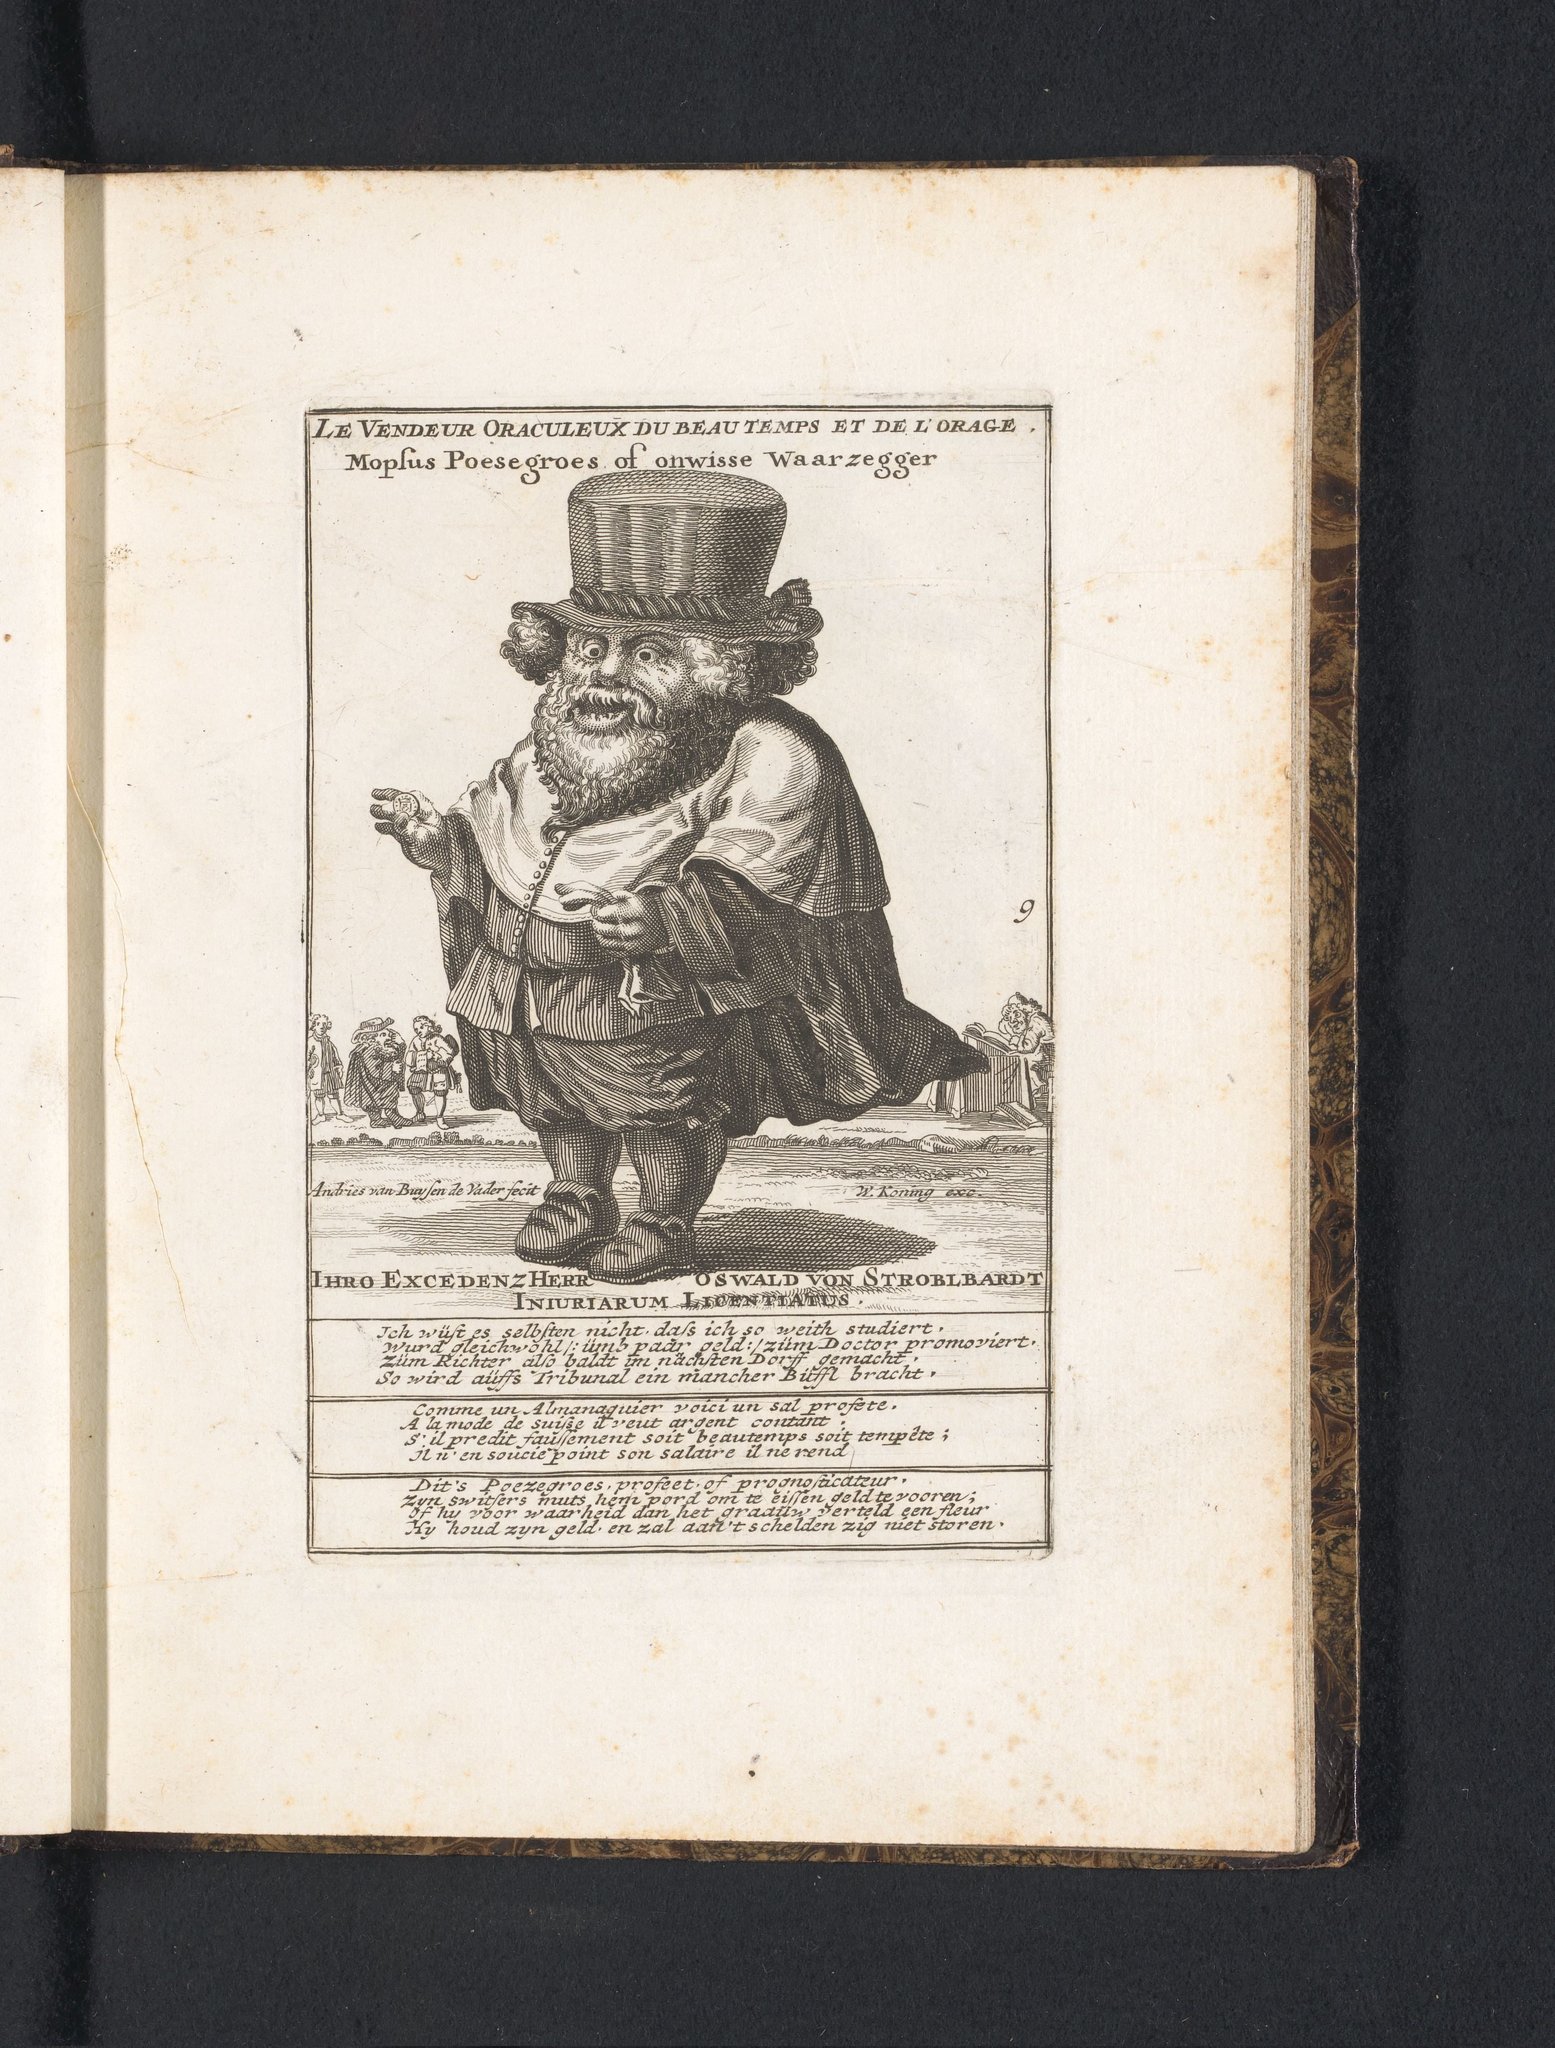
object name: print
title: Le vendeur oraculeux du beau temps et de l'orage / Mopsus Poesegroes of onwisse Waarzegger / Ihro Excedenz Herr Oswald von Stroblbardt Iniuriarum Licentiatus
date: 1718-1720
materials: paper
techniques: etching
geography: amsterdam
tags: caricatures (human types), little people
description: De kleine mens Mopsus Poesegroes als waarzegger met een geldstuk in de hand. In het onderschrift verzen in het Duits, Frans en Nederlands. Genummerd rechts midden: 9. Onderdeel van de tweede Nederlandse gebonden uitgave uit 1720 (en gerelateerd aan de Windhandel in dat jaar) van een serie karikaturen van kleine mensen, bekend als Het Dwergentooneel.